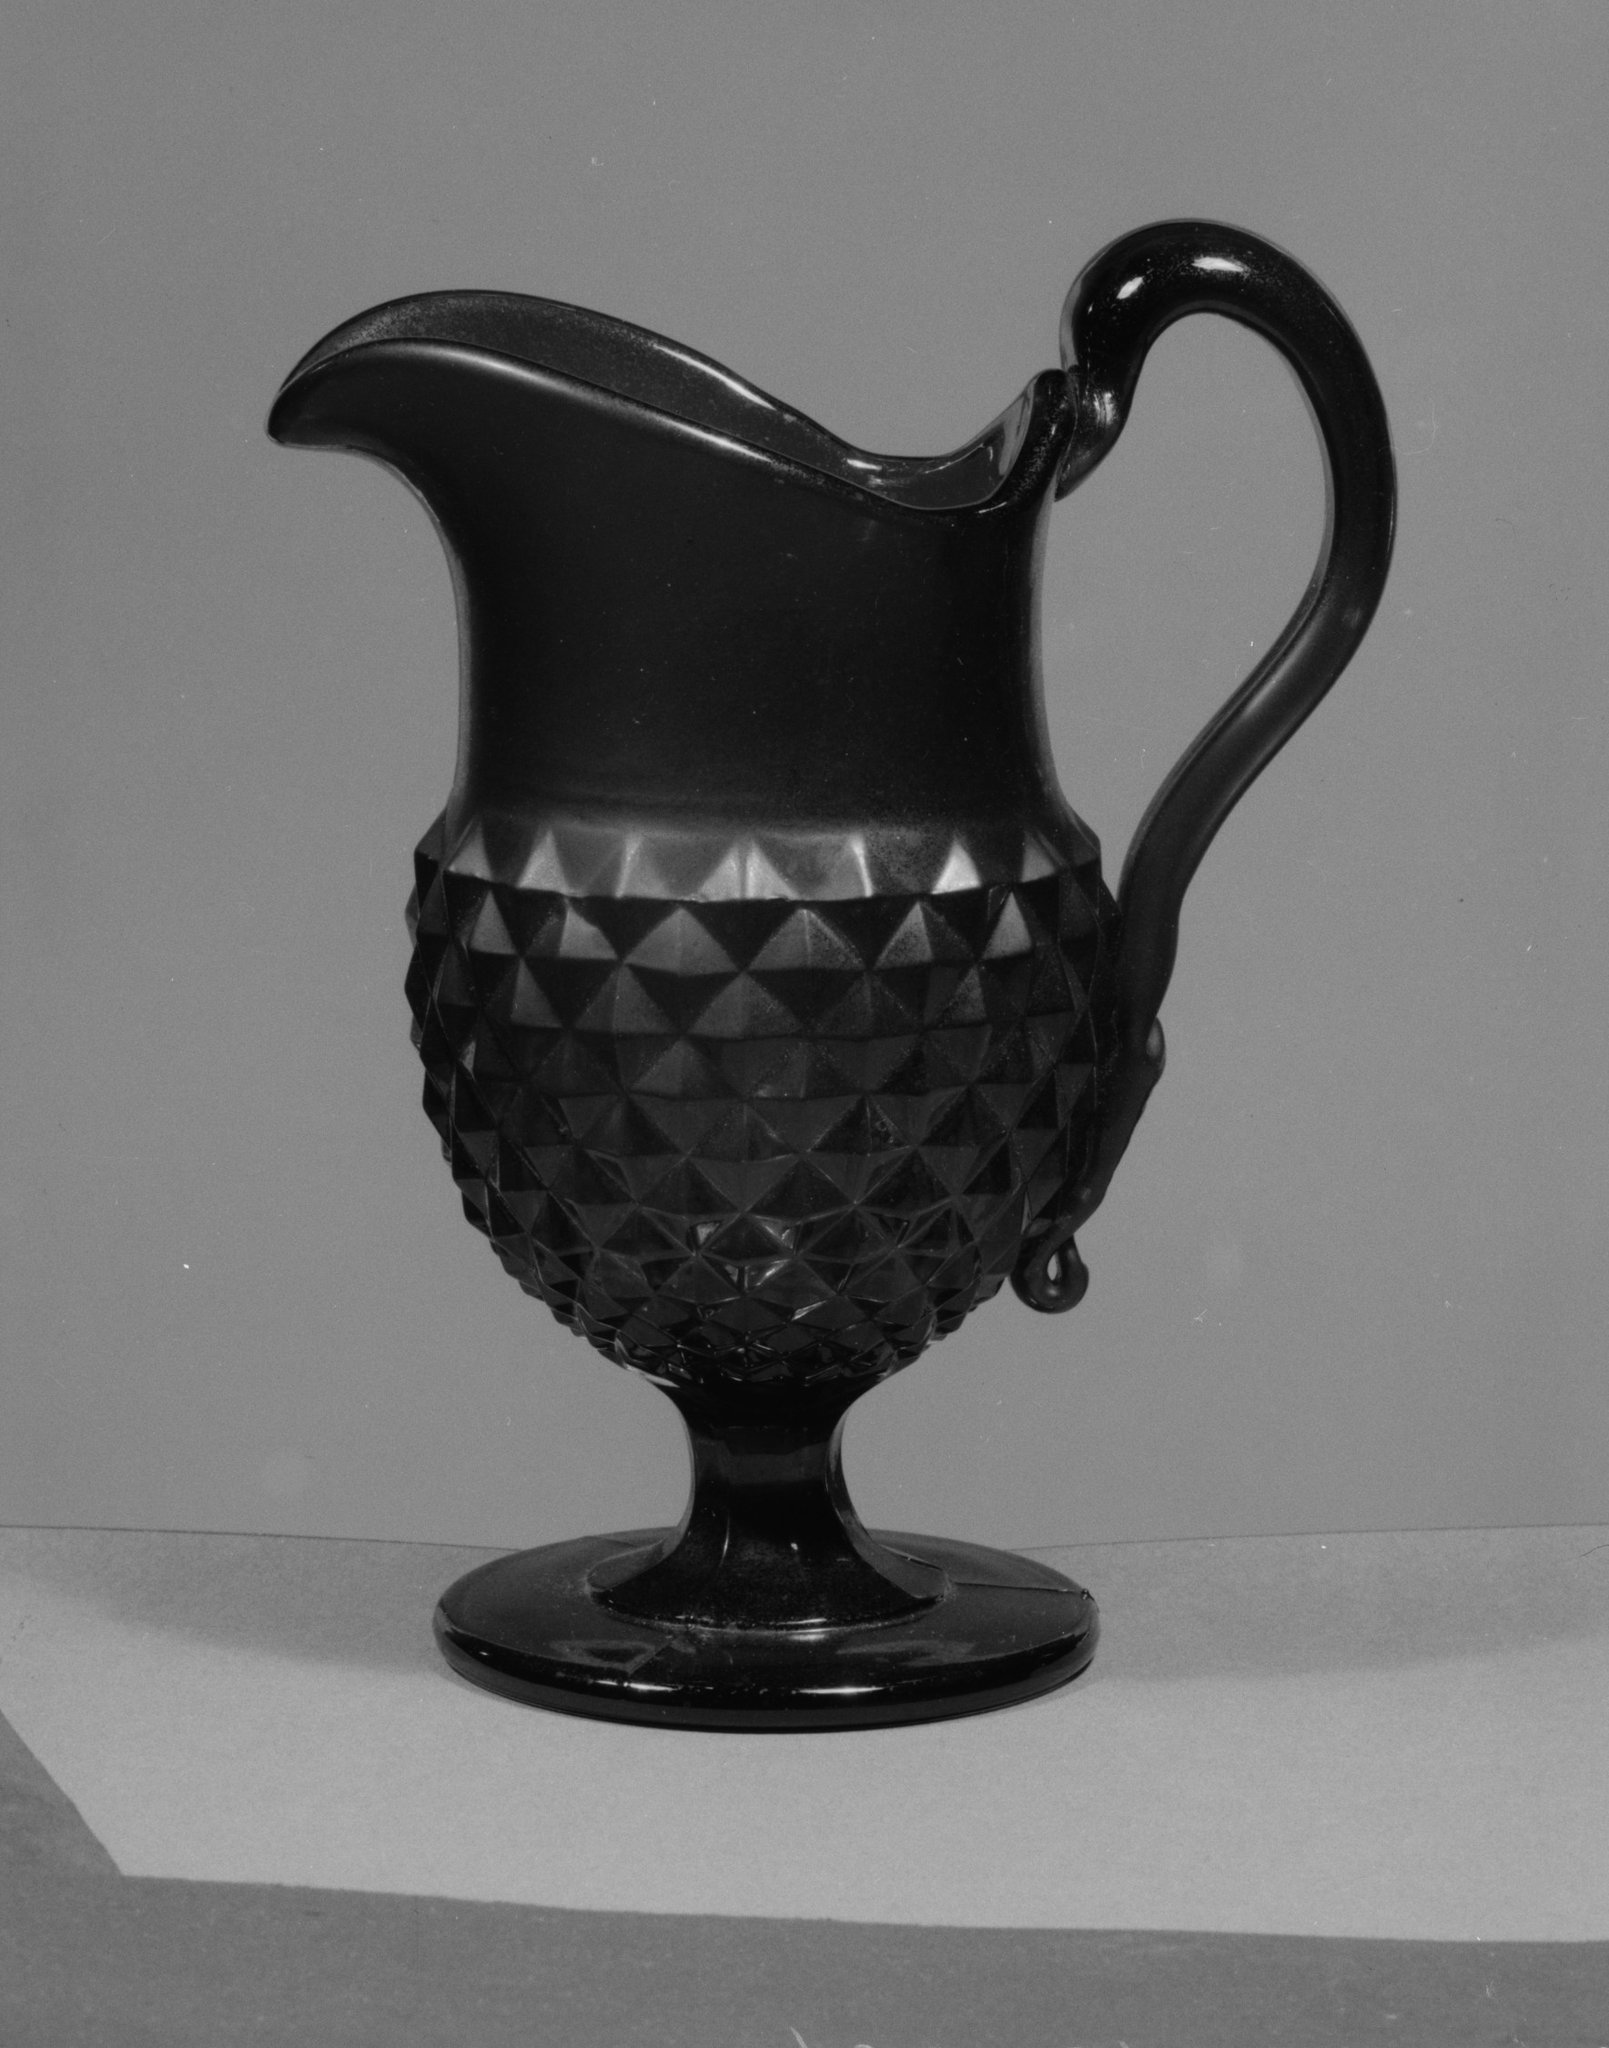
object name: cream pot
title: Creamer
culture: american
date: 1870-1885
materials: glass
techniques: pressed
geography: united states